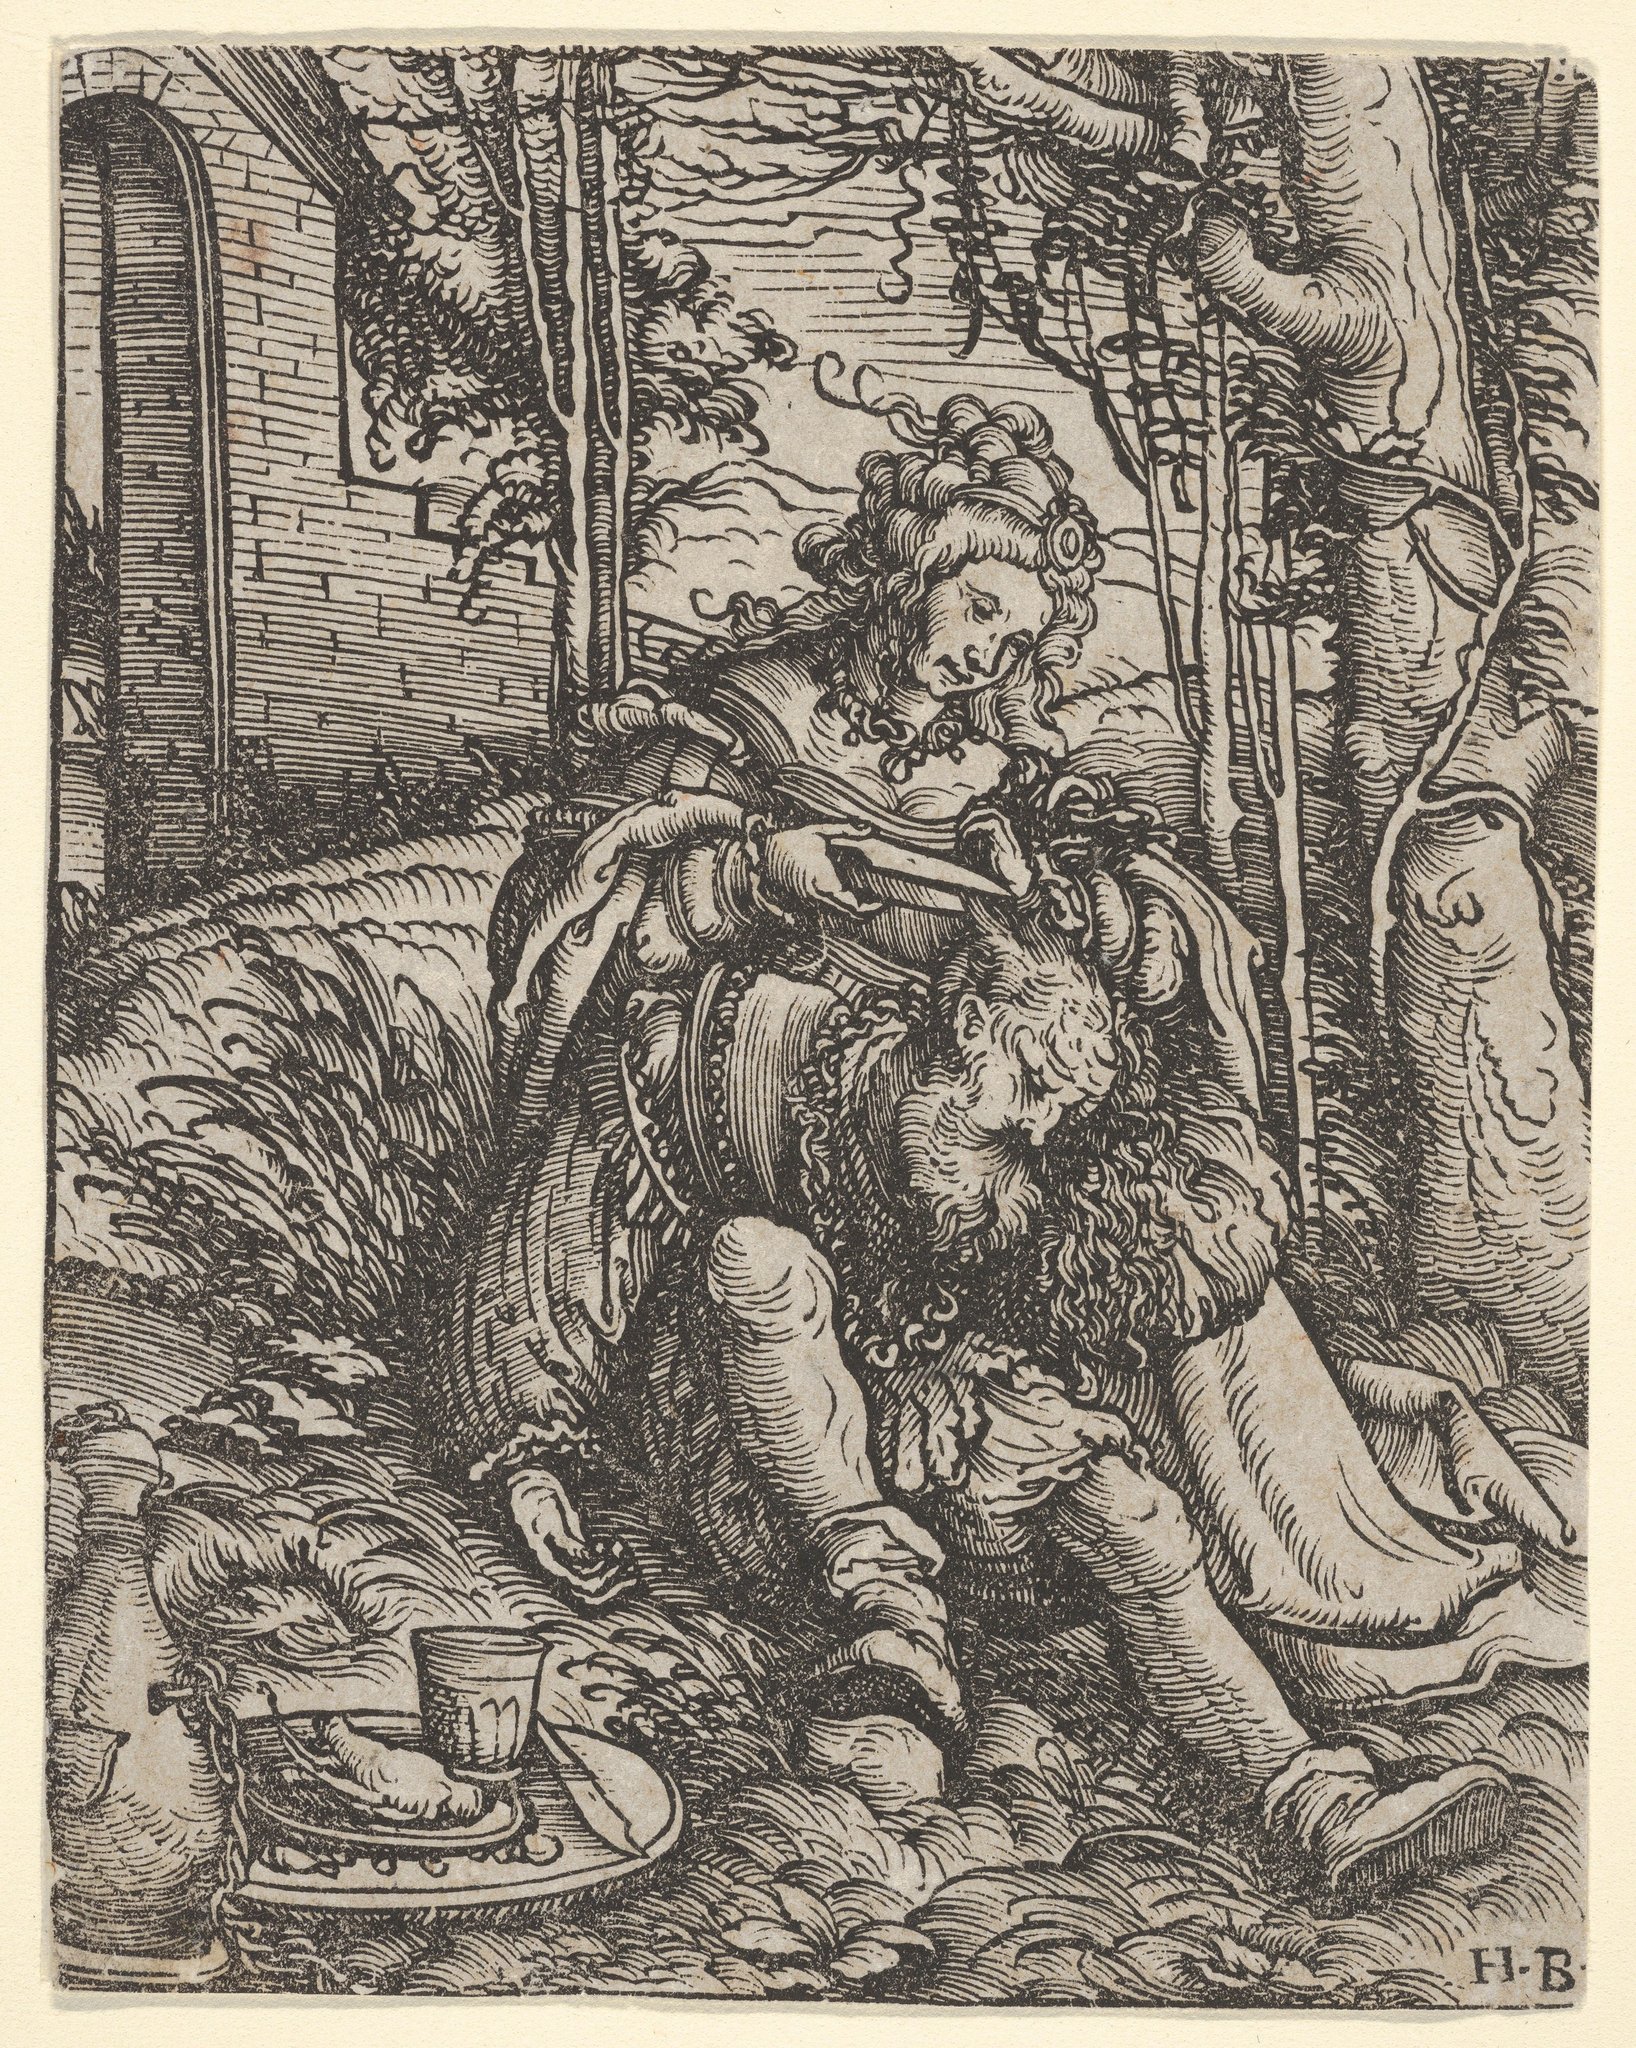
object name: print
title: Samson and Delilah, from "Women's Wile" (Weiberlisten)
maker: hans burgkmair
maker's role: artist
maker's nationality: german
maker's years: 1473-1531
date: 1498-1531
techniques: woodcut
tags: women,samson